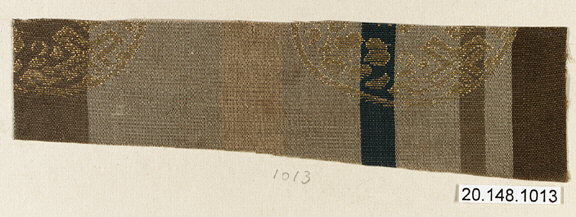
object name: piece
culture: japanese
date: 1701-1800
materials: silk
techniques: compound weave